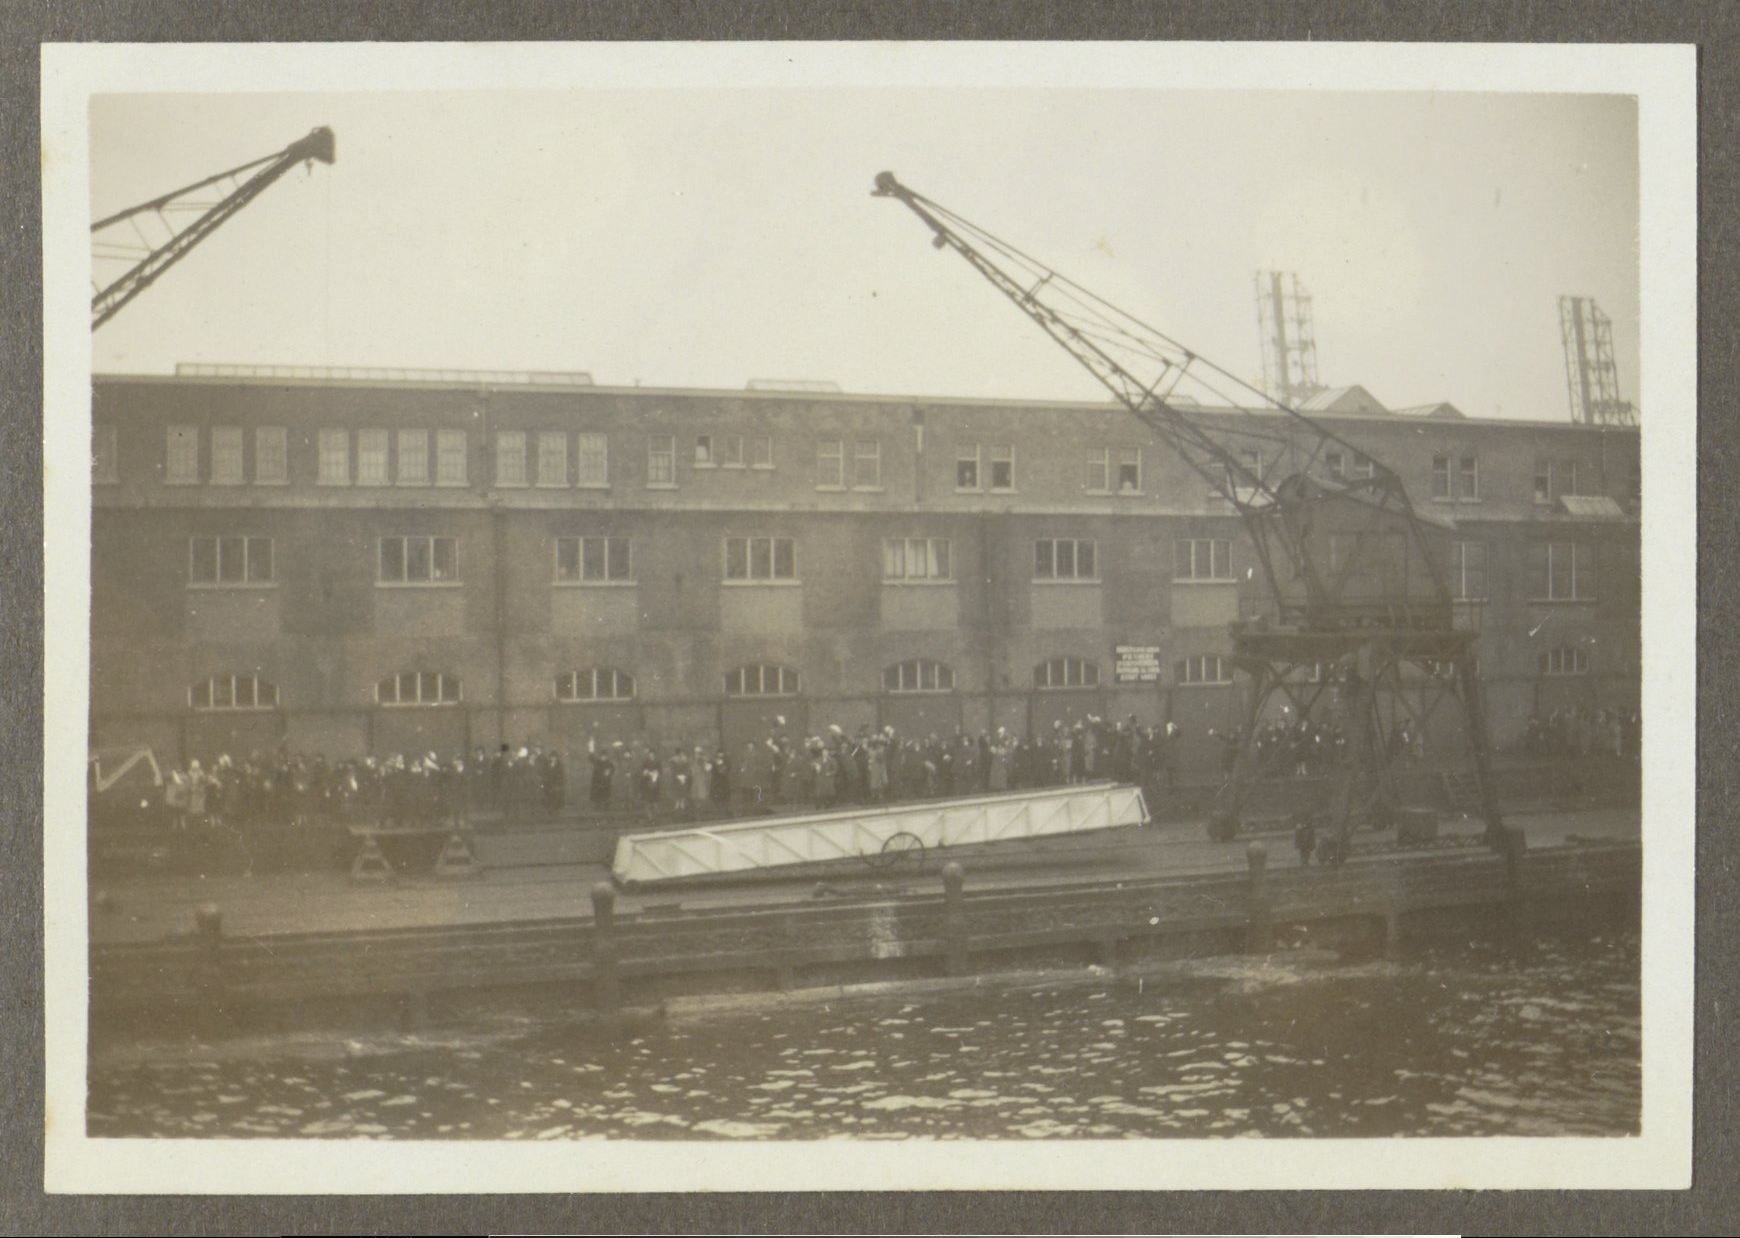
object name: photograph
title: Wuivende mensen, een hijskraan en een valreep op een kade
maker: Anonymous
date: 1920-1930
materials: photographic support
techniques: gelatin silver print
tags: pier, quay, wharf, waving farewell ~ departure on a journey, netherlands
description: Onderdeel van familiealbum Nederlands-Indië.